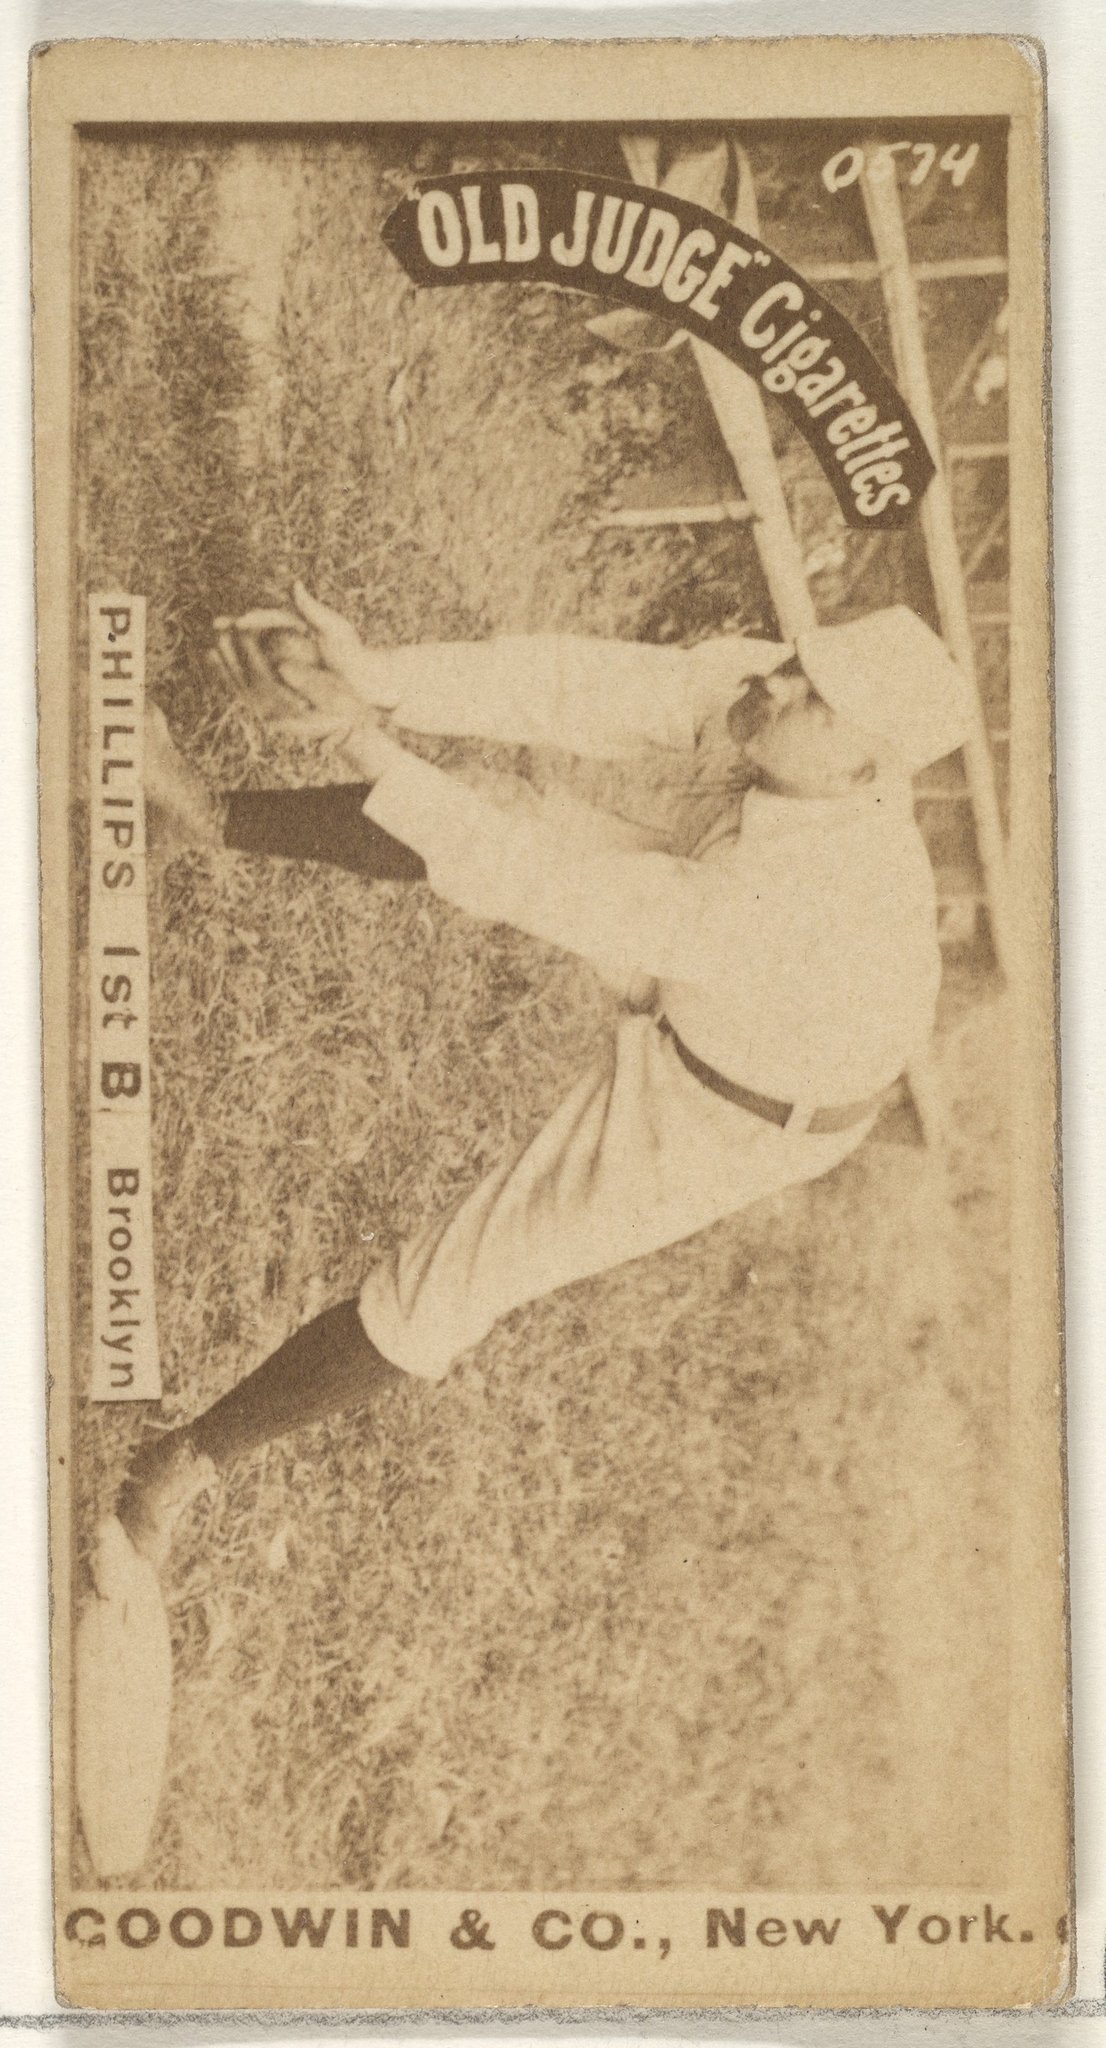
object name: baseball card, photograph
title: Phillips, 1st Base, Brooklyn, from the Old Judge series (N172) for Old Judge Cigarettes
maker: goodwin & company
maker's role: publisher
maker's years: 1850-1950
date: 1887-1890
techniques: albumen silver print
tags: men,portraits,baseball,athletes